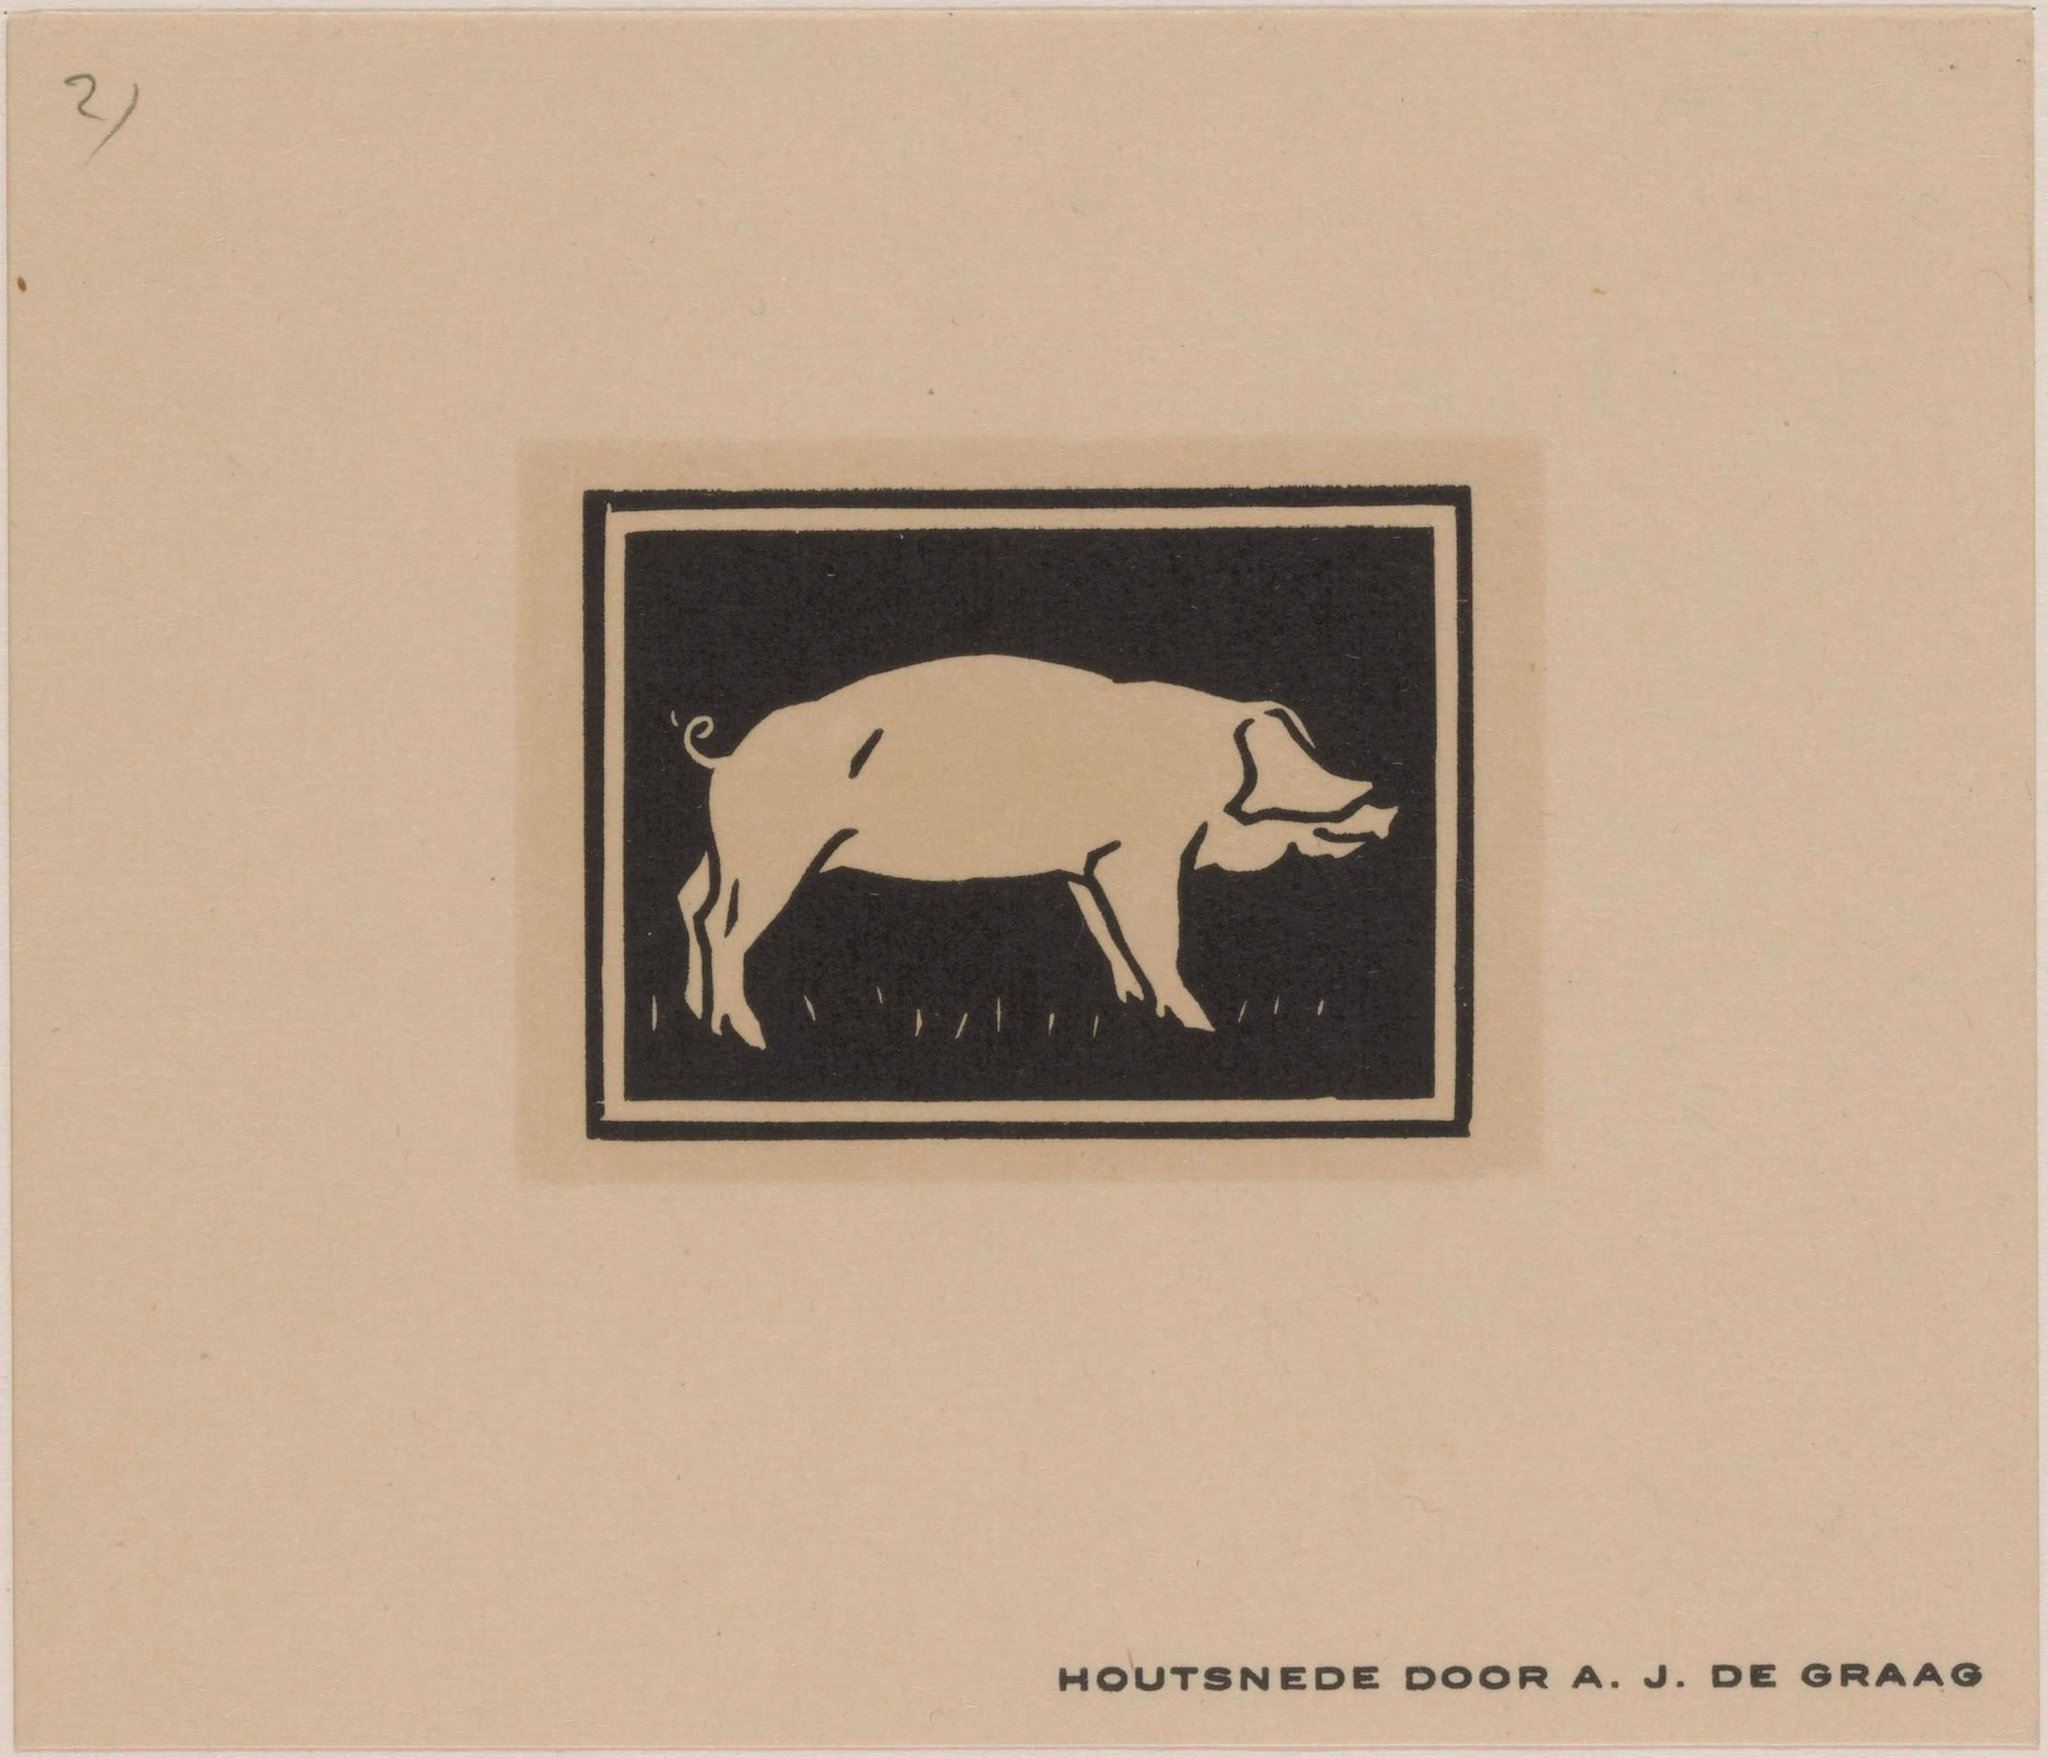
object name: print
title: Varken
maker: julie de graag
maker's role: draughtsman, print maker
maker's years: 1877-1924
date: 1923-1924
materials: paper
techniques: woodcut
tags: pig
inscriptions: collector's mark: Lugt 2228